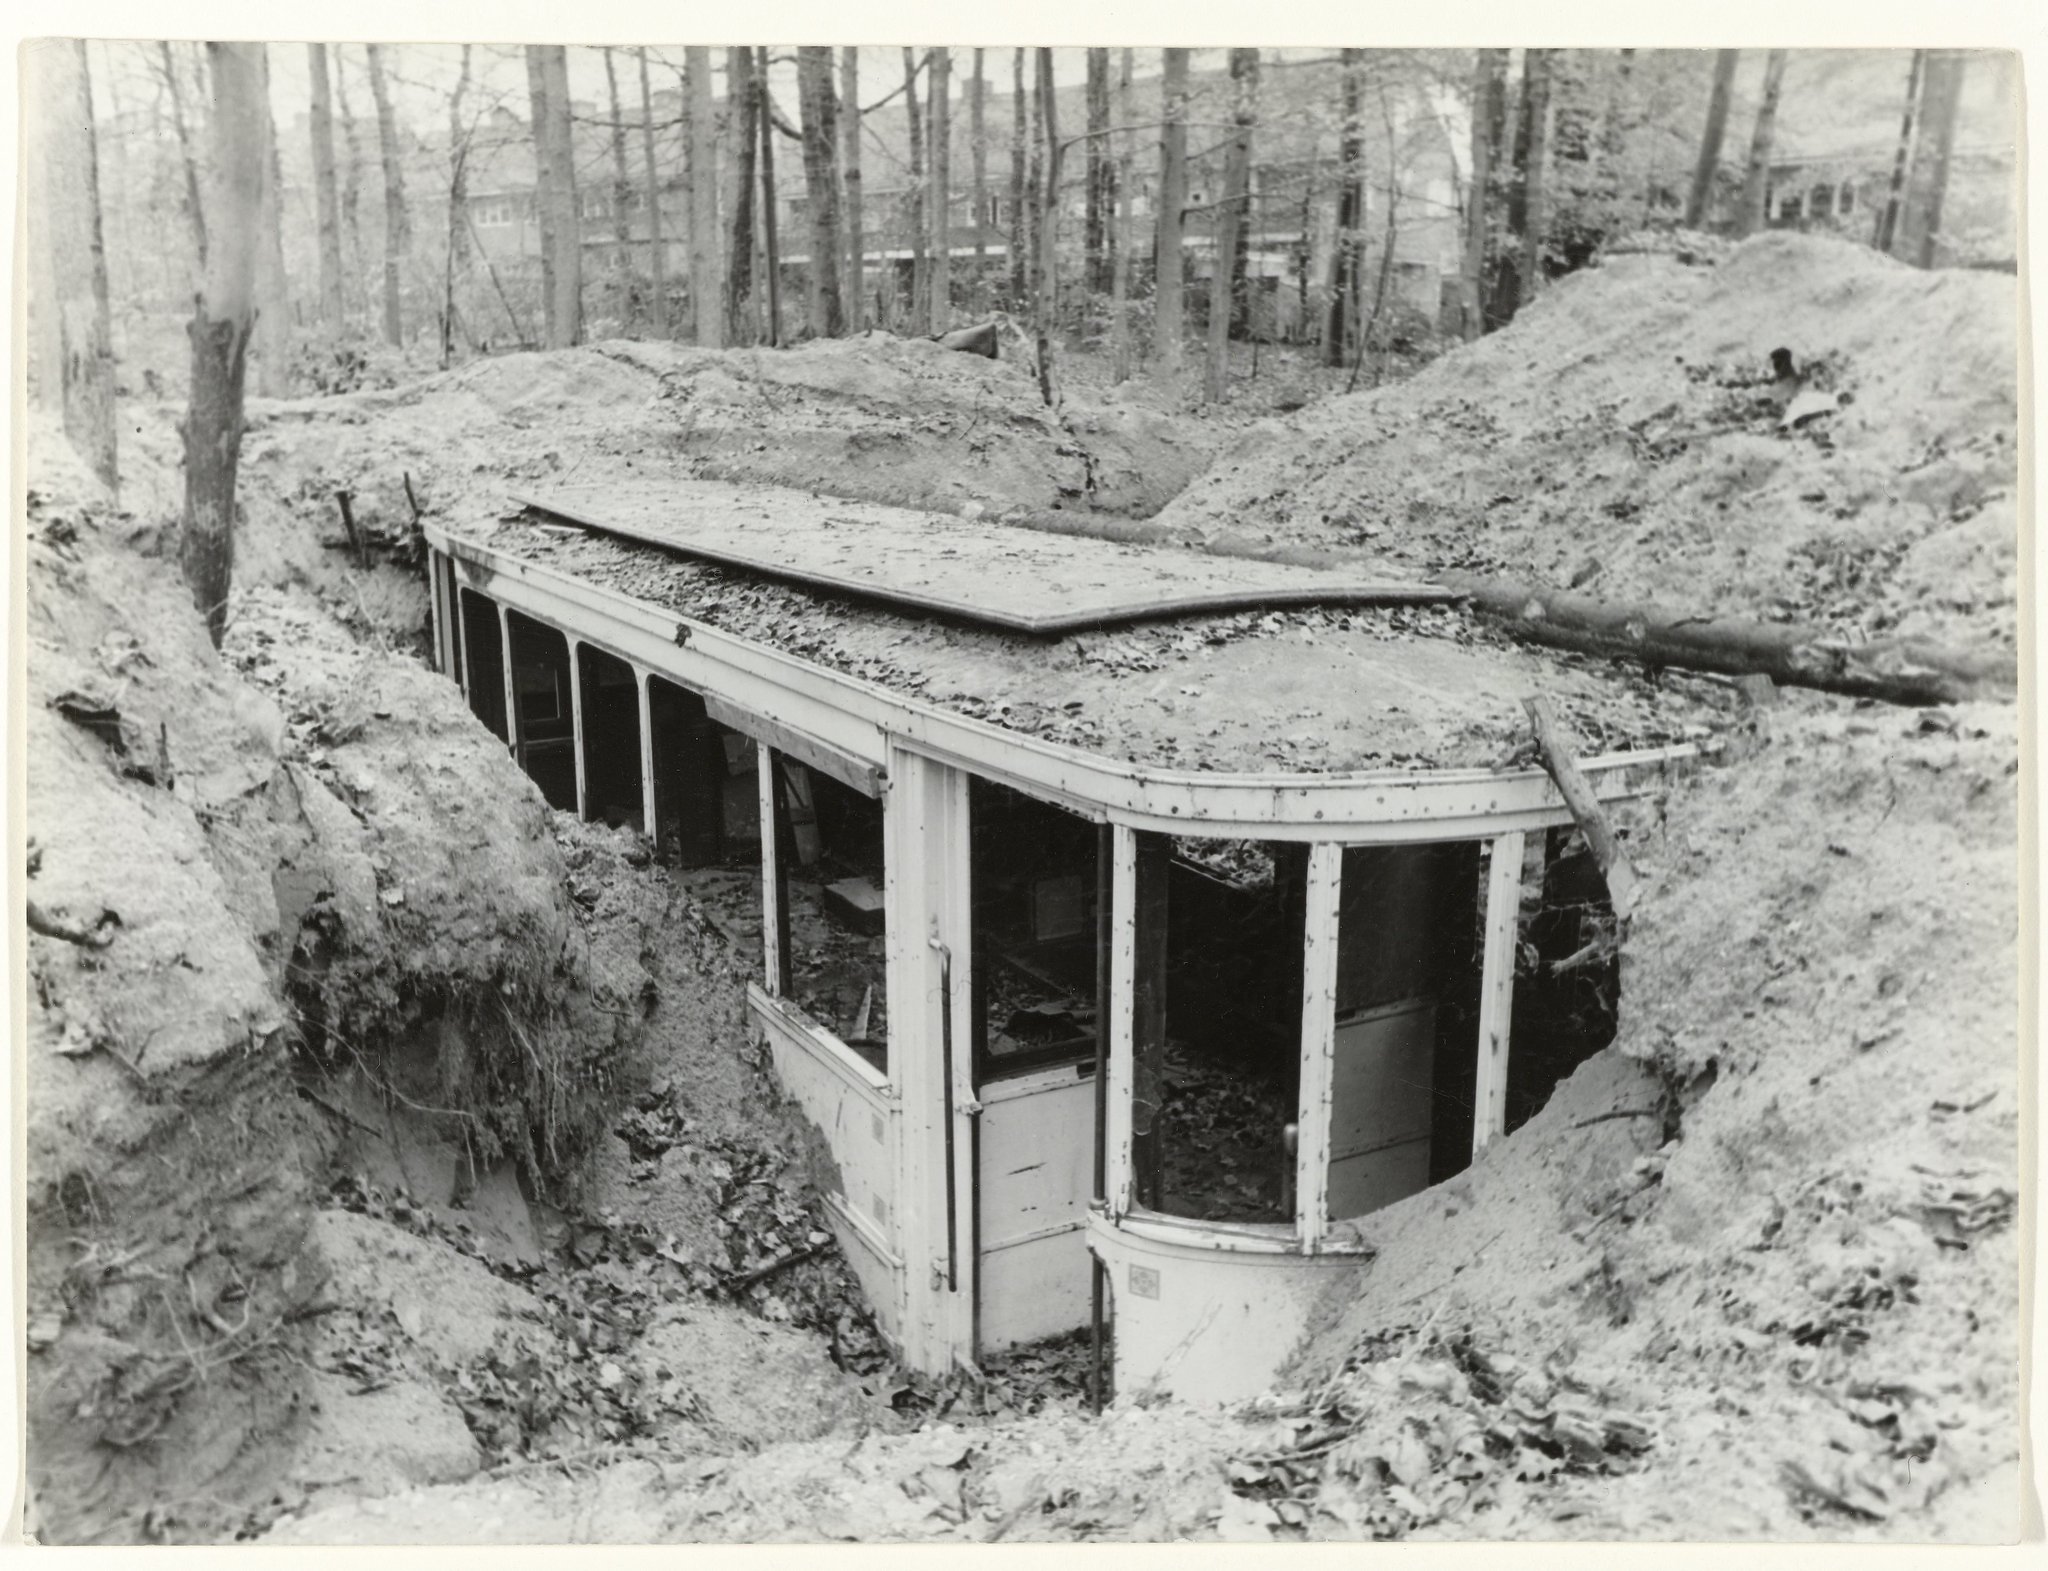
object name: photograph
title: Ingegraven tramwagons te Arnhem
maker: dick renes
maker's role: fotograaf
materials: photographic support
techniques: photography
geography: arnhem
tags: arnhem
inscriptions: inscription, stamp: ‘COPYRIGHT / 'ANEFO' / ALGEMEEN NEDERLANDSCH FOTOBUREAU’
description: Ingegraven tramwagons te Arnhem. De Duitsers hadden ze ingegraven ter bescherming voor aanvallen vanuit de lucht.